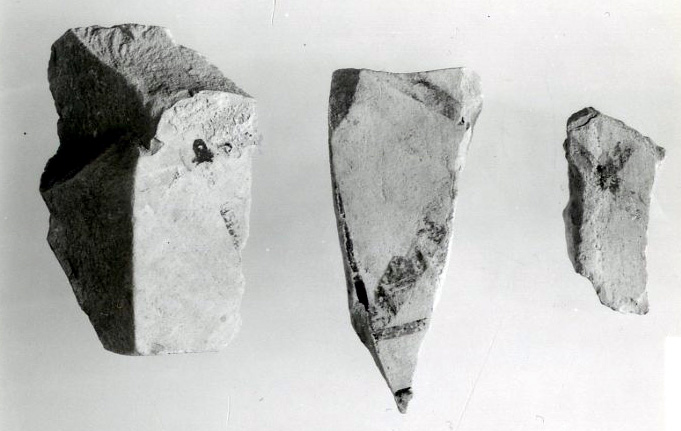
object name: relief fragment, tomb of meketre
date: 1981-1975 BCE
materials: limestone, paint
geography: egypt